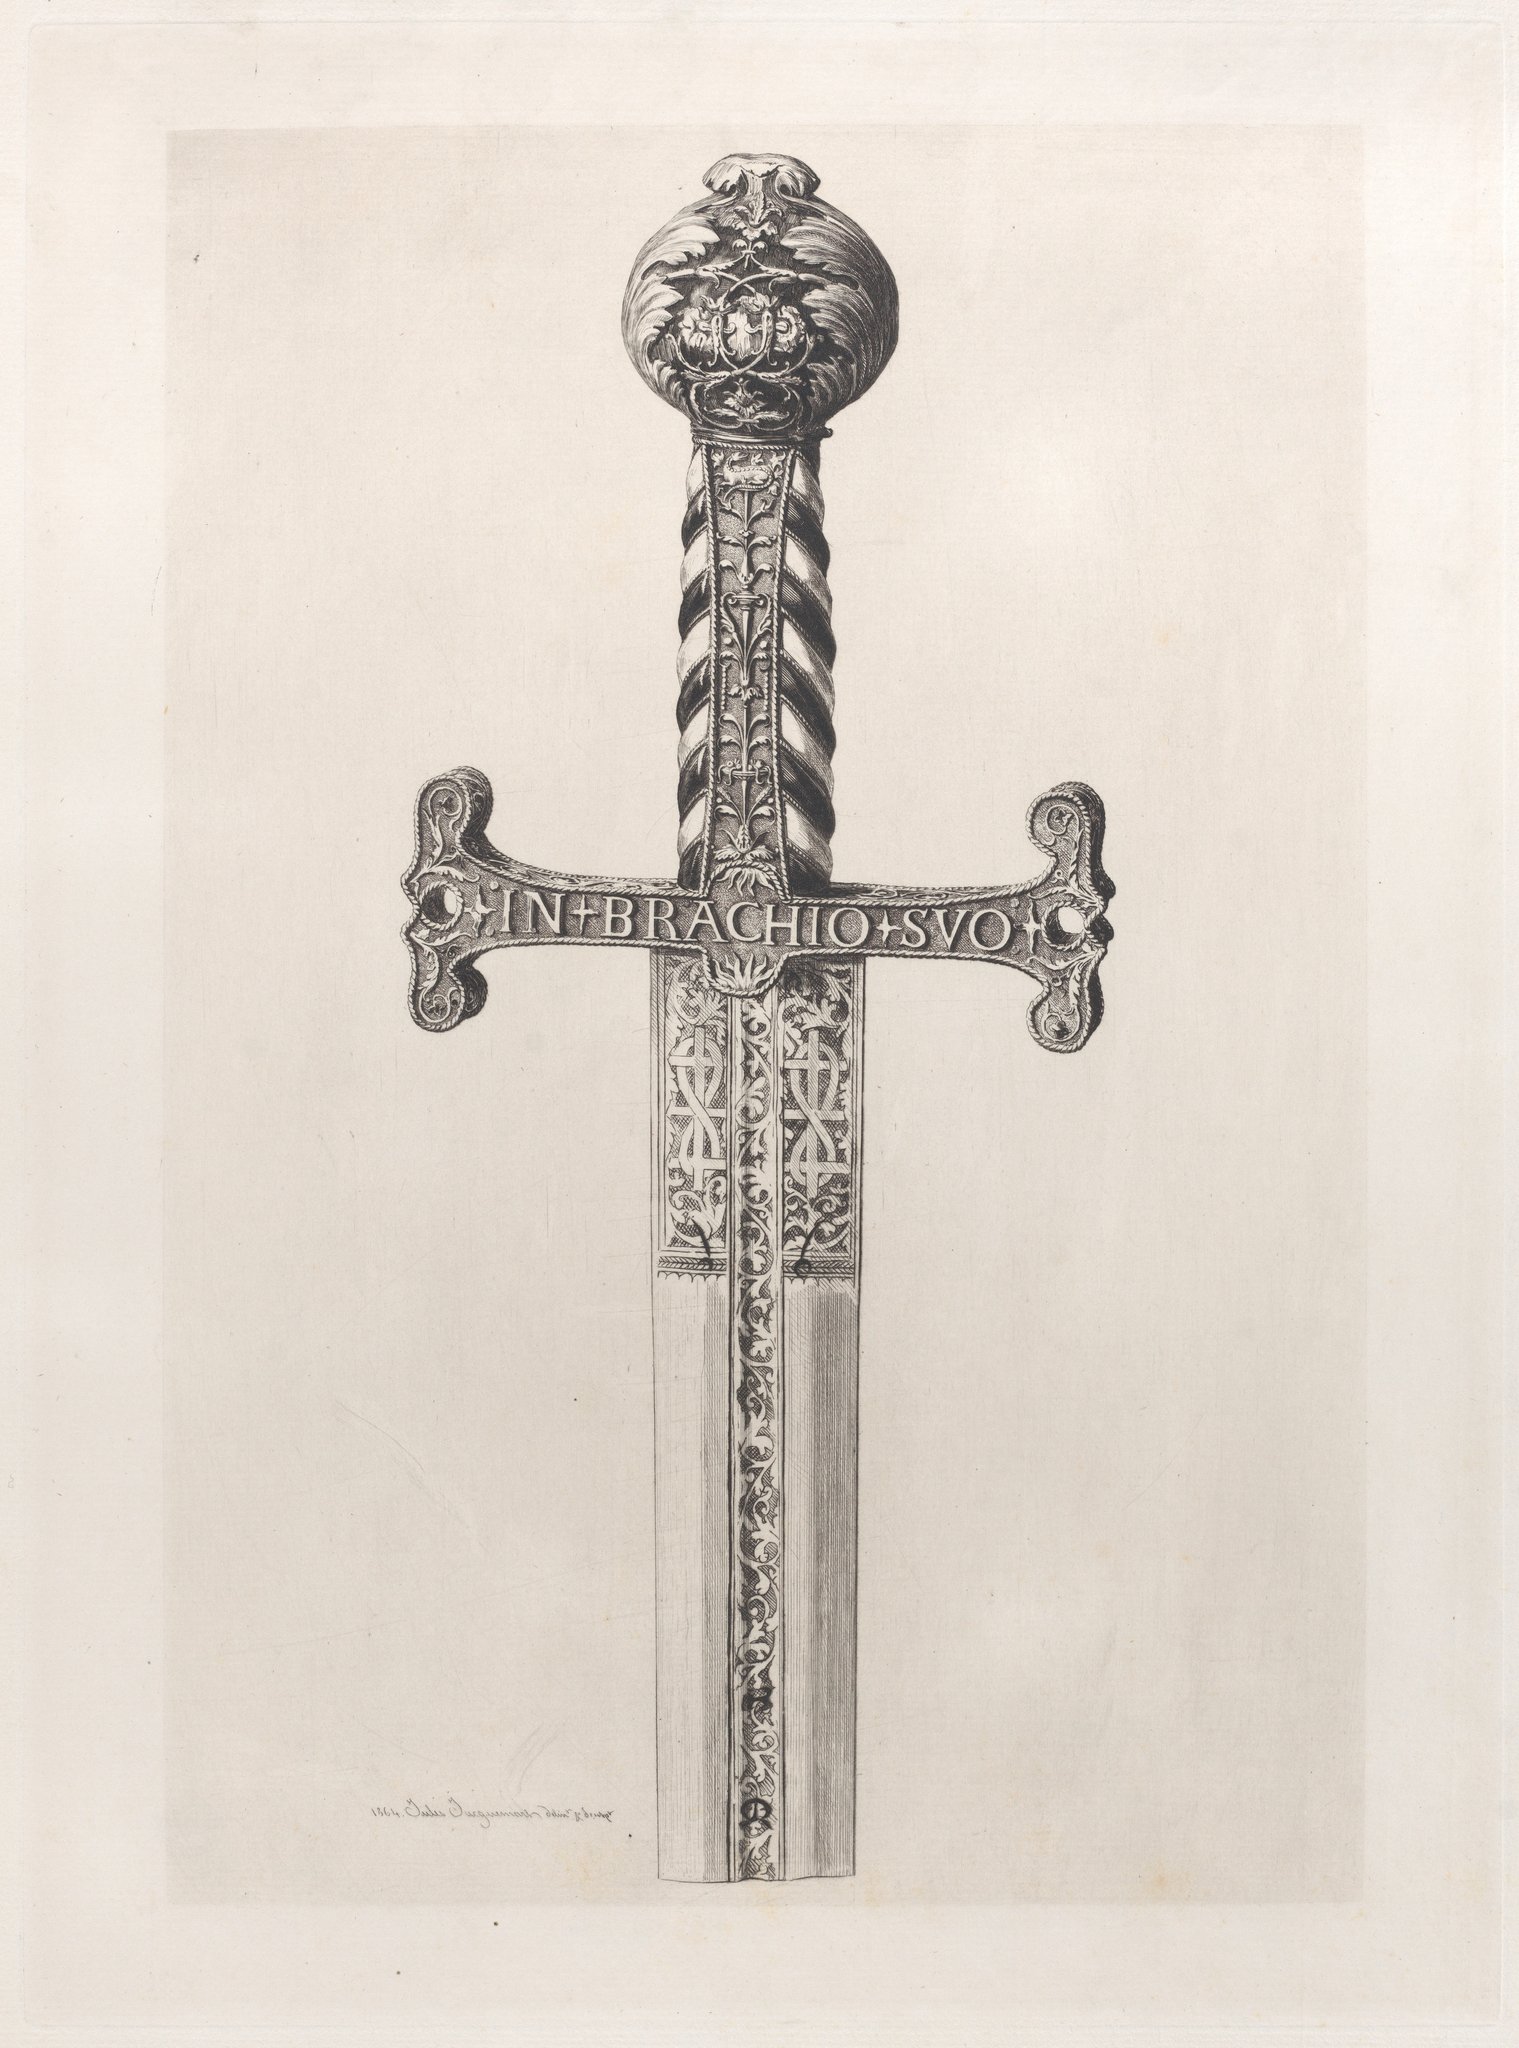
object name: print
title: François Ier's Sword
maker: jules-ferdinand jacquemart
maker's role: artist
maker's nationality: french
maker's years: 1837-1880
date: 1864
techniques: etching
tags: swords